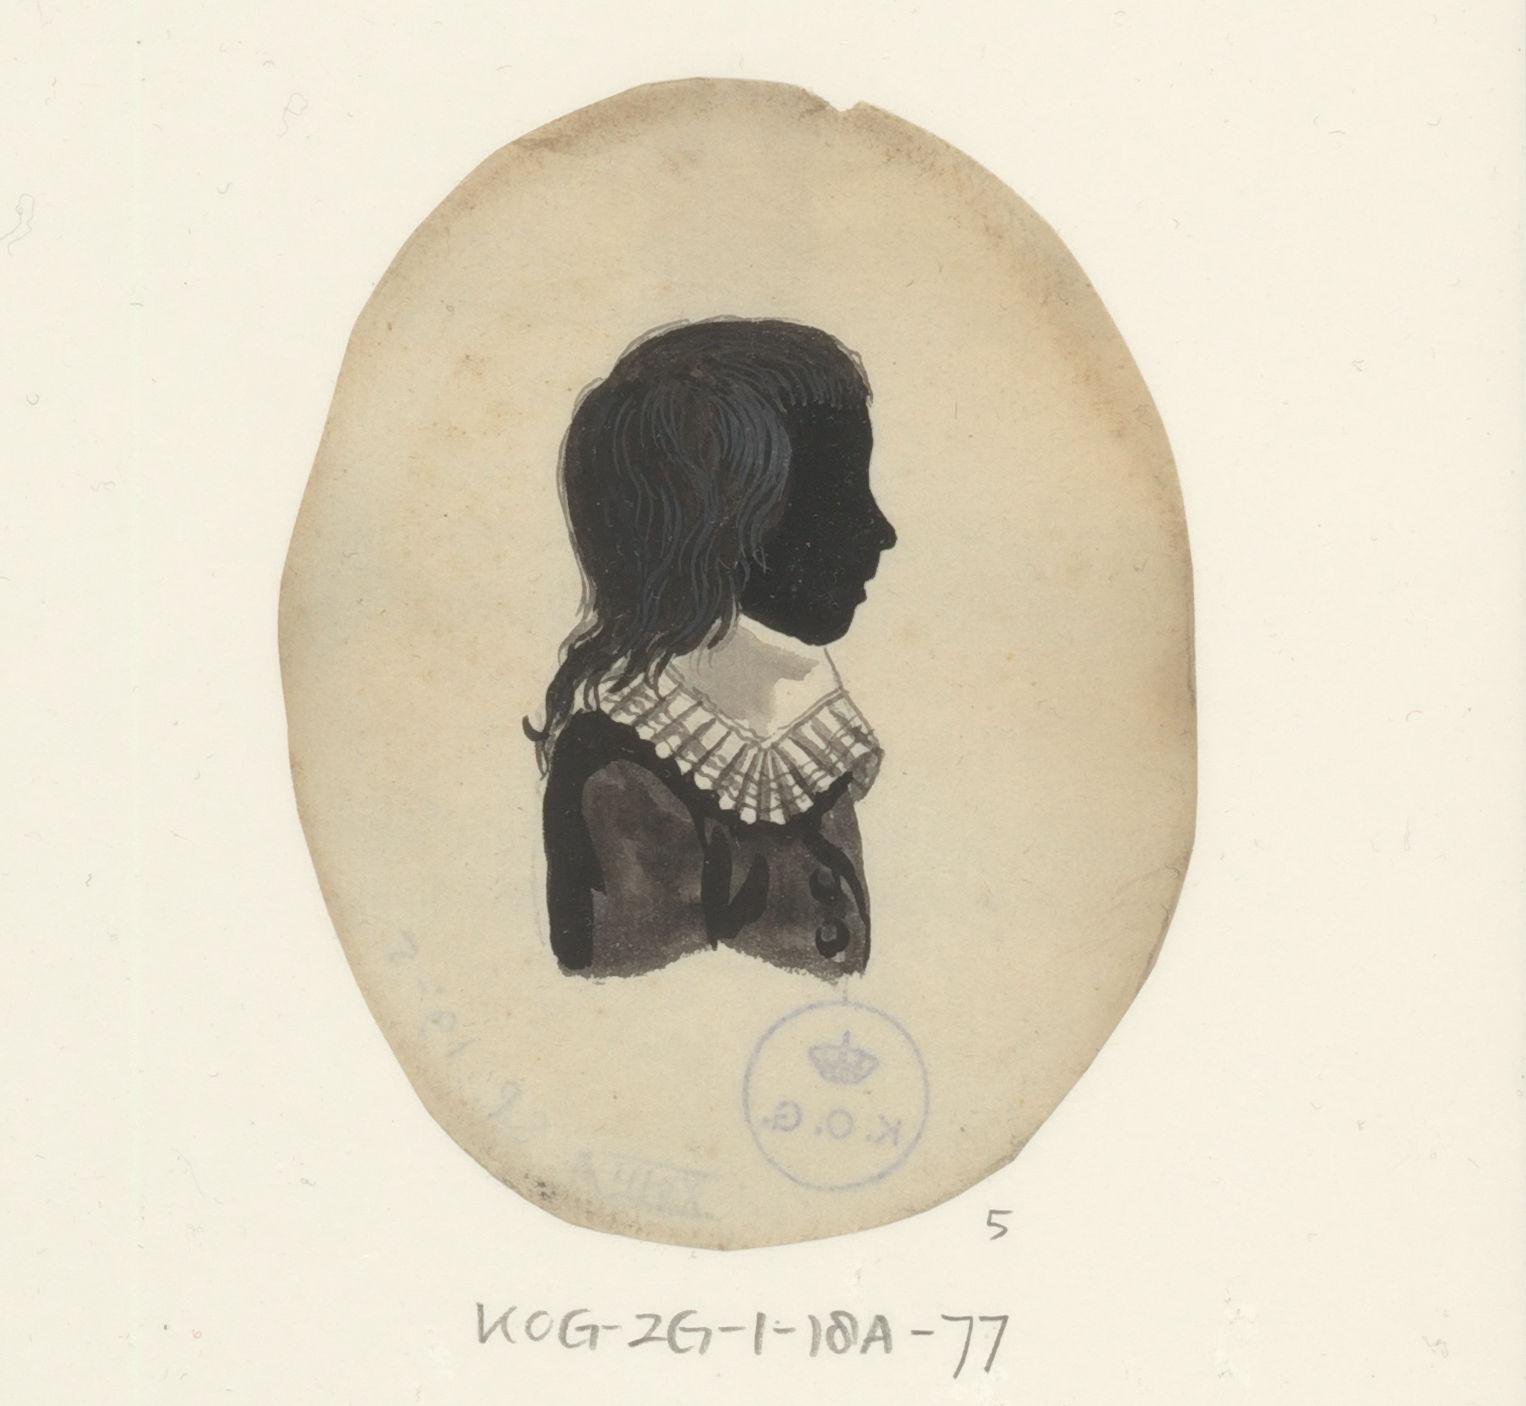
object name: silhouette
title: Silhouetportret van een onbekende jongen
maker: Anonymous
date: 1775-1849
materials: ink, paper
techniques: brush, pen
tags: boy (child between toddler and youth), historical persons not known by name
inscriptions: collector's mark: Lugt 1641a, collector's mark: Lugt 1641, stamp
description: Silhouetportret van een onbekende jongen. Hij draagt een platte kraag met geplooide rand. Onderwerpsrubrieken binnen de Atlas Zeden en Gewoonten: Schoone kunsten, Silhouetportretten.